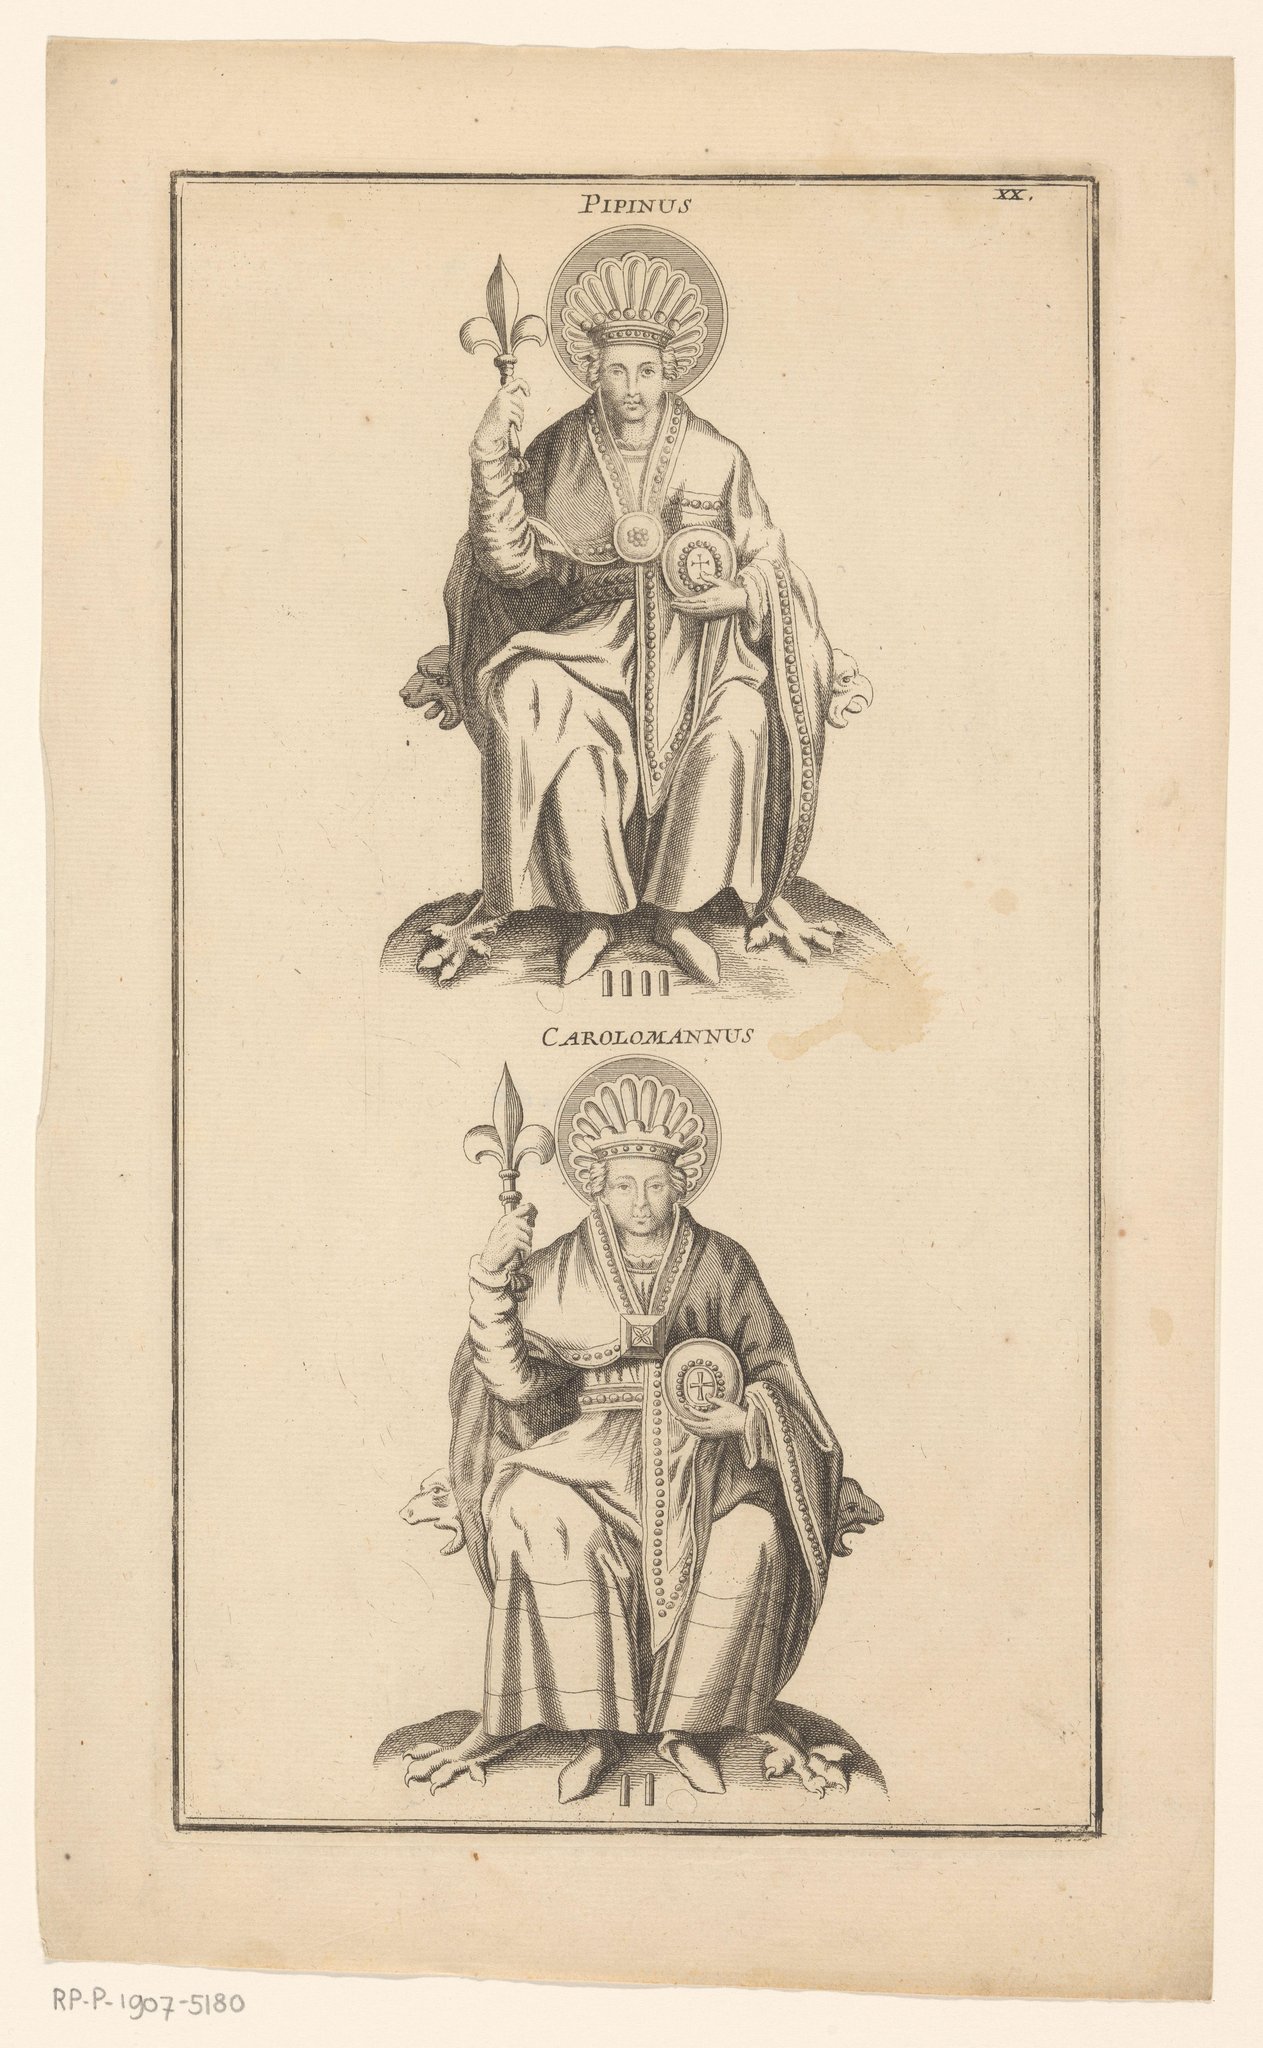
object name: book illustration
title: Portretten van de koningen Pepijn en Carloman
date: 1729-1733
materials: paper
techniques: engraving, etching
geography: paris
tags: vienne, liège, historical persons, king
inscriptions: collector's mark: Lugt 2228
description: Prent uit: Montfaucon, Bernard de. Les monumens de la monarchie françoise, qui comprennent l'histoire de France avec les figures de chaque règne que l'injure des tems a épargnées (...). Parijs: Julien-Michel Gandouin en Pierre-François Giffart, 1729-1733, dl. 1, afb. voor p. 273.